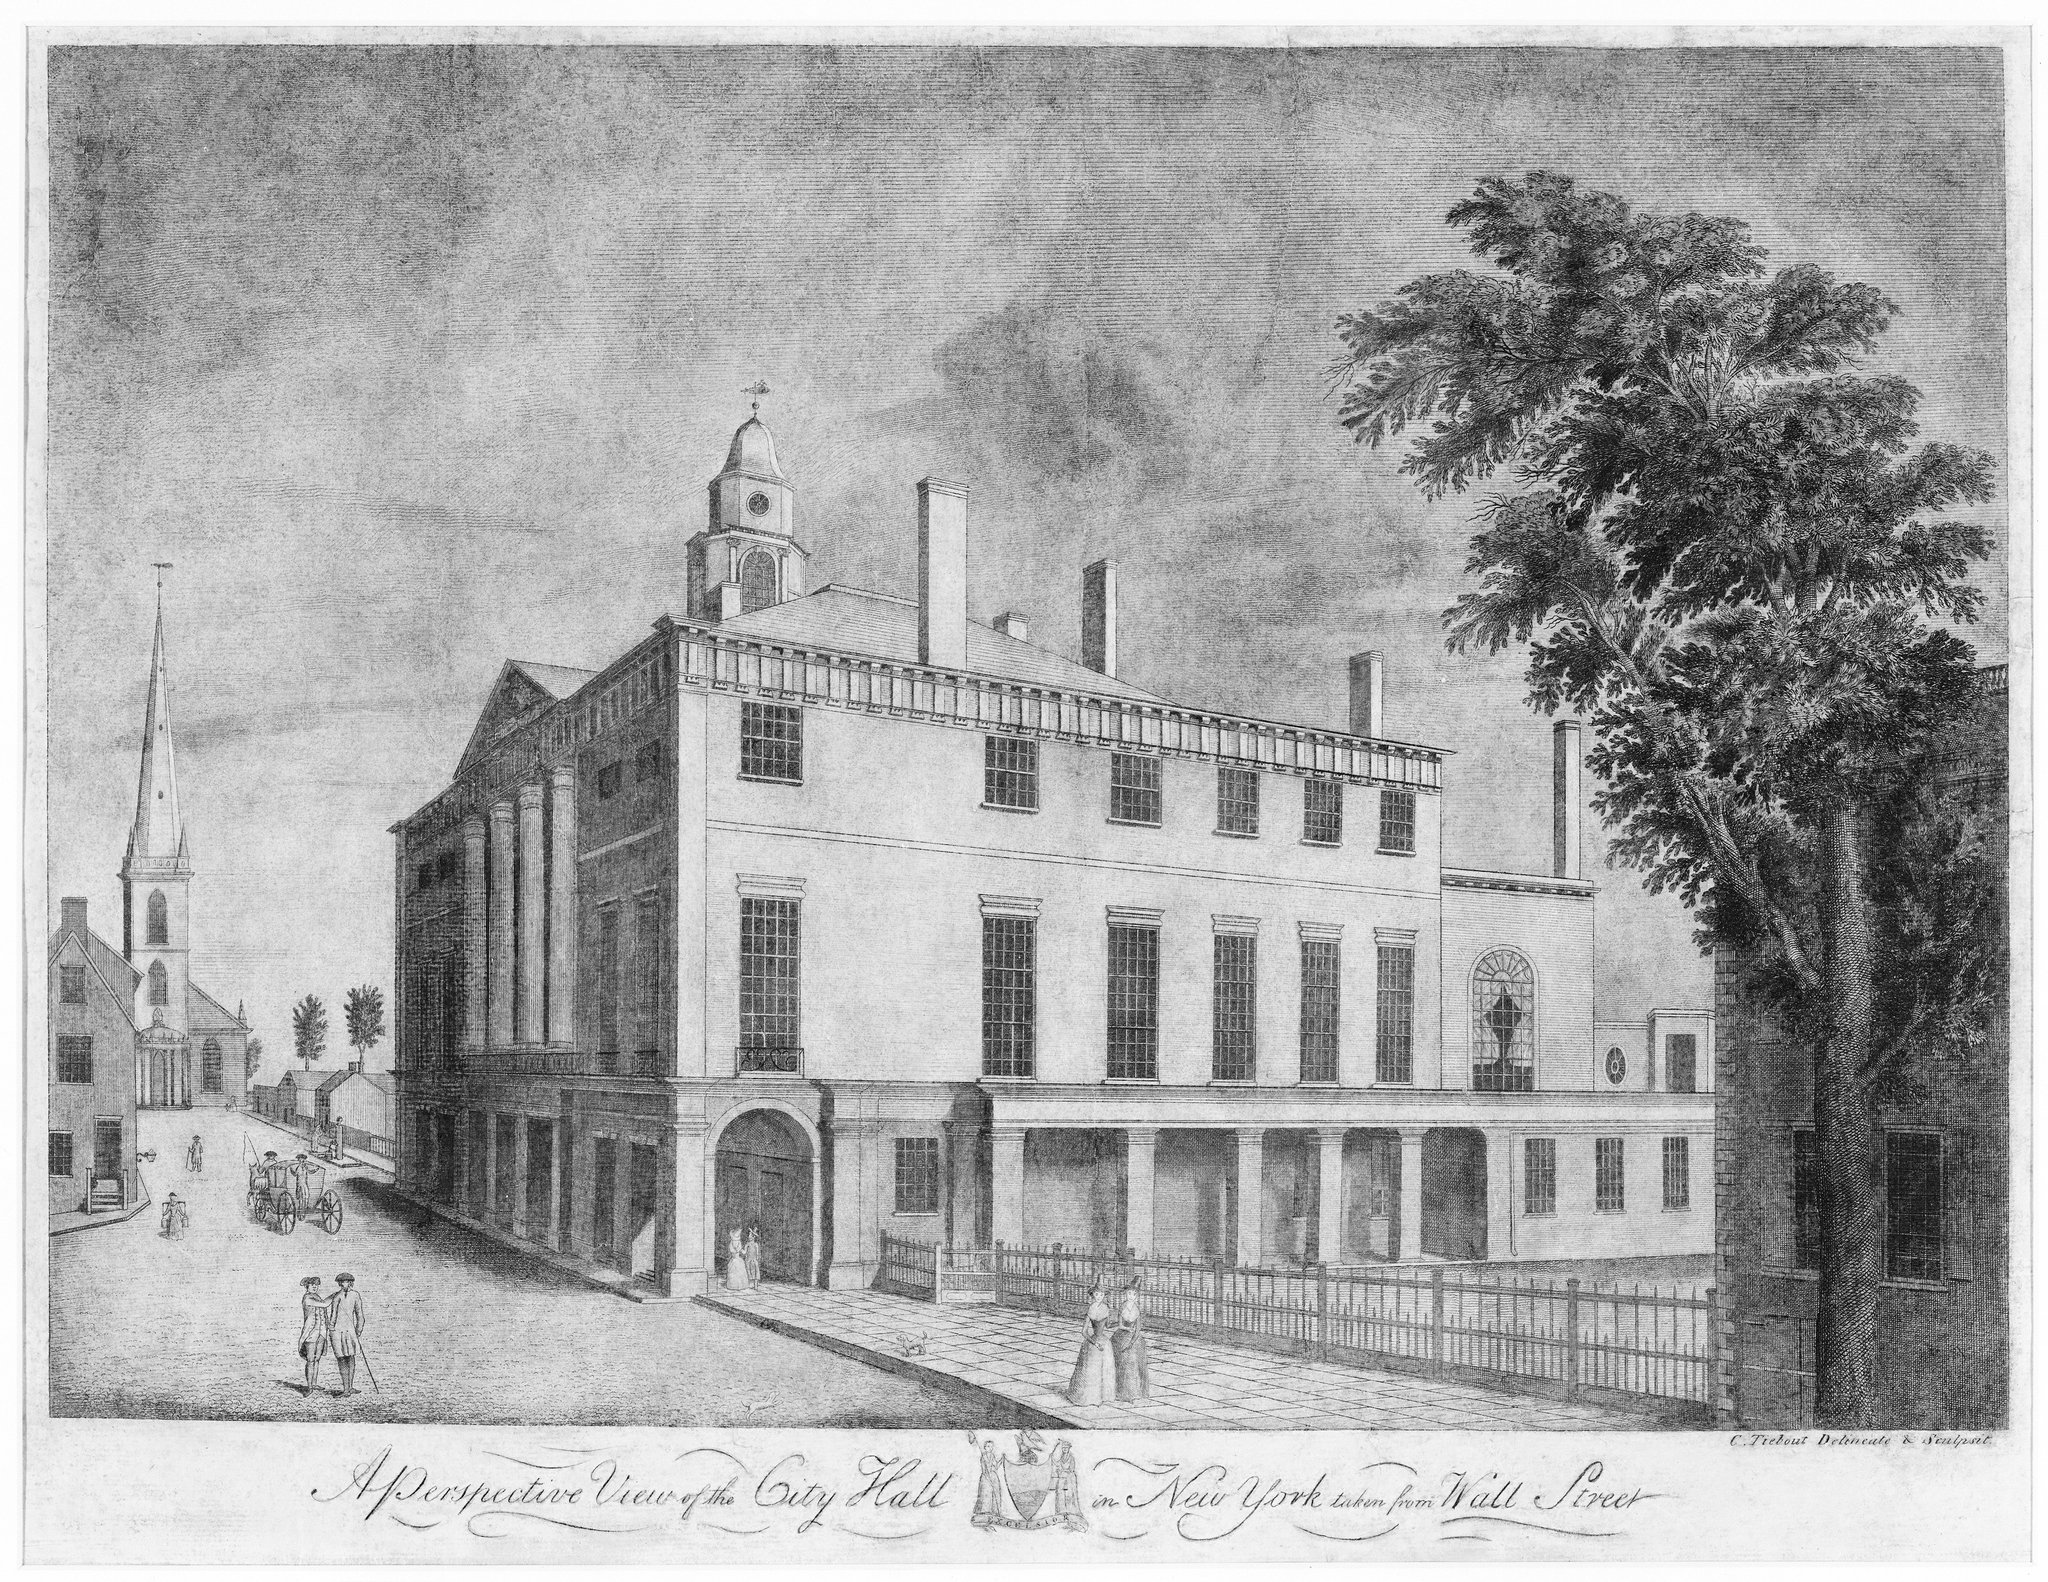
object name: print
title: A Perspective View of the City Hall in New York, Taken from Wall Street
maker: cornelius tiebout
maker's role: artist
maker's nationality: american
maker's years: 1773-1832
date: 1791-1793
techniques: engraving, etching, hand coloring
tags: buildings,new york city